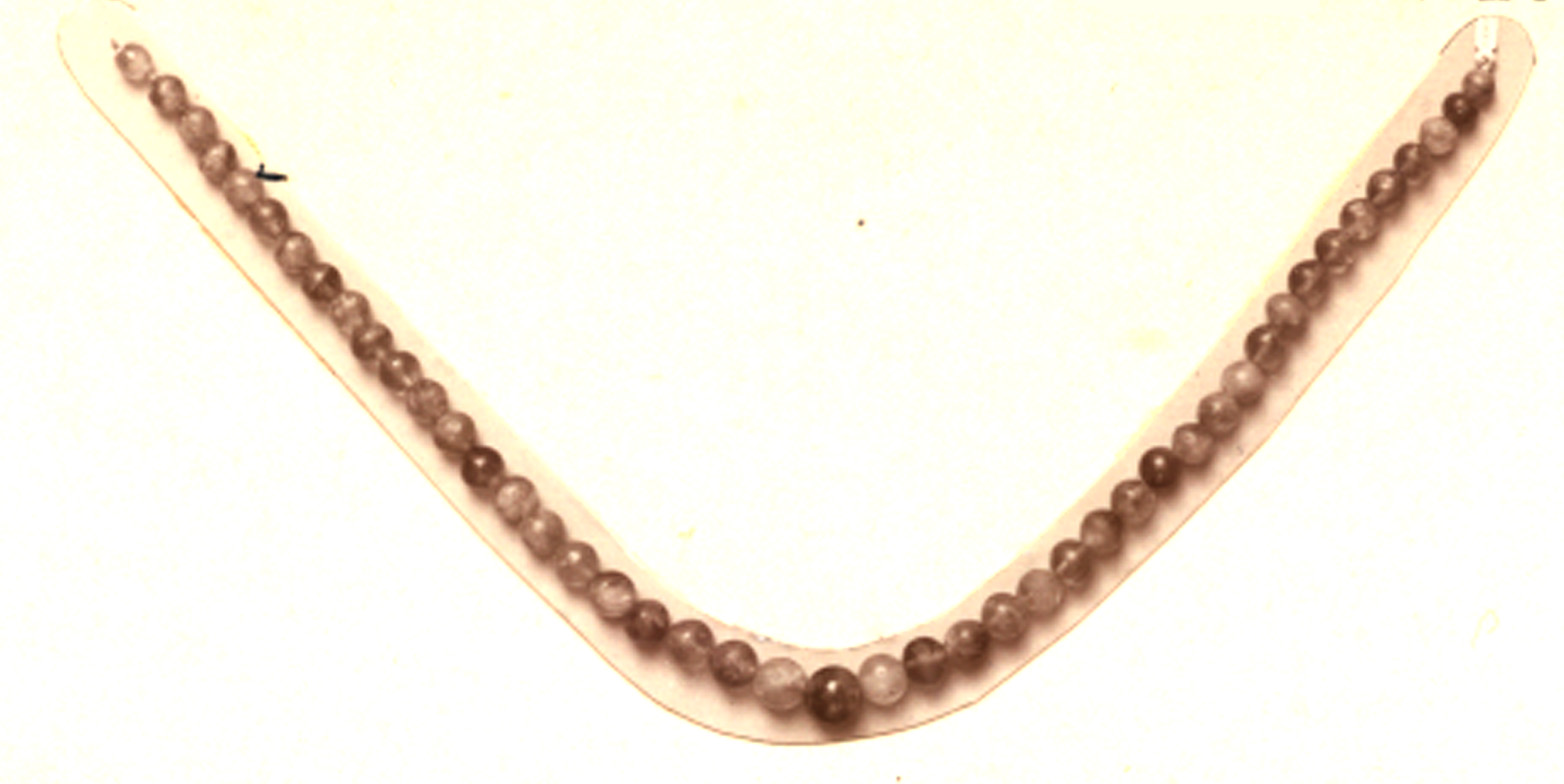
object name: necklace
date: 2030-1650 BCE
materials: gemstone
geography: egypt